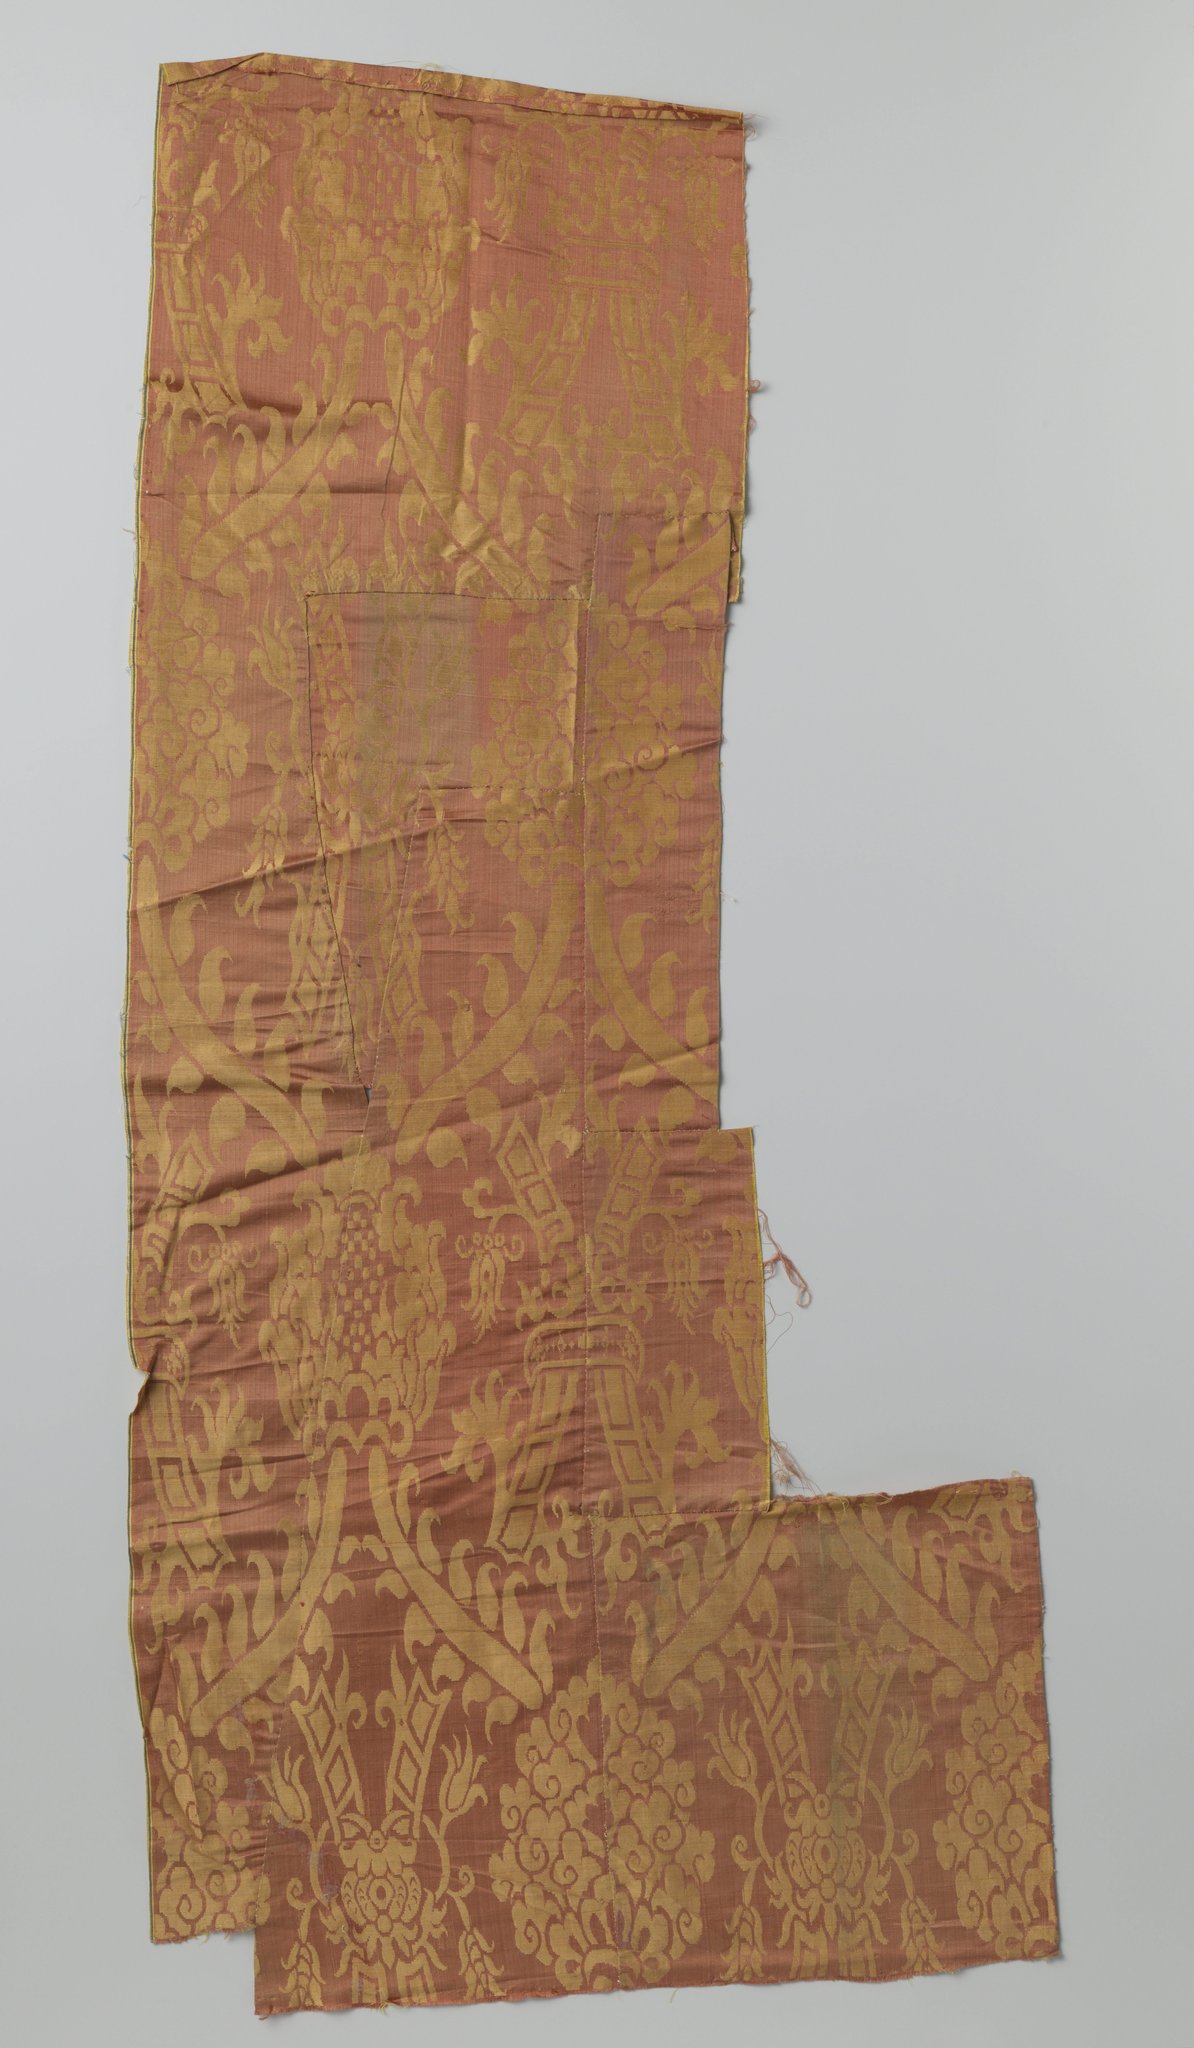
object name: zijdedamast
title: Zijdedamast, waarschijnlijk onderdeel van een liturgisch gewaad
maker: Anonymous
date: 1500-1600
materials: silk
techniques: damask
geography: italy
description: Zes aan elkaar genaaide fragmenten zijdedamast, zelfde patroon als delen van twee bijhorende manipels. Het patroon heeft in geel op rood een gestileerd bloem- en bladmotief.